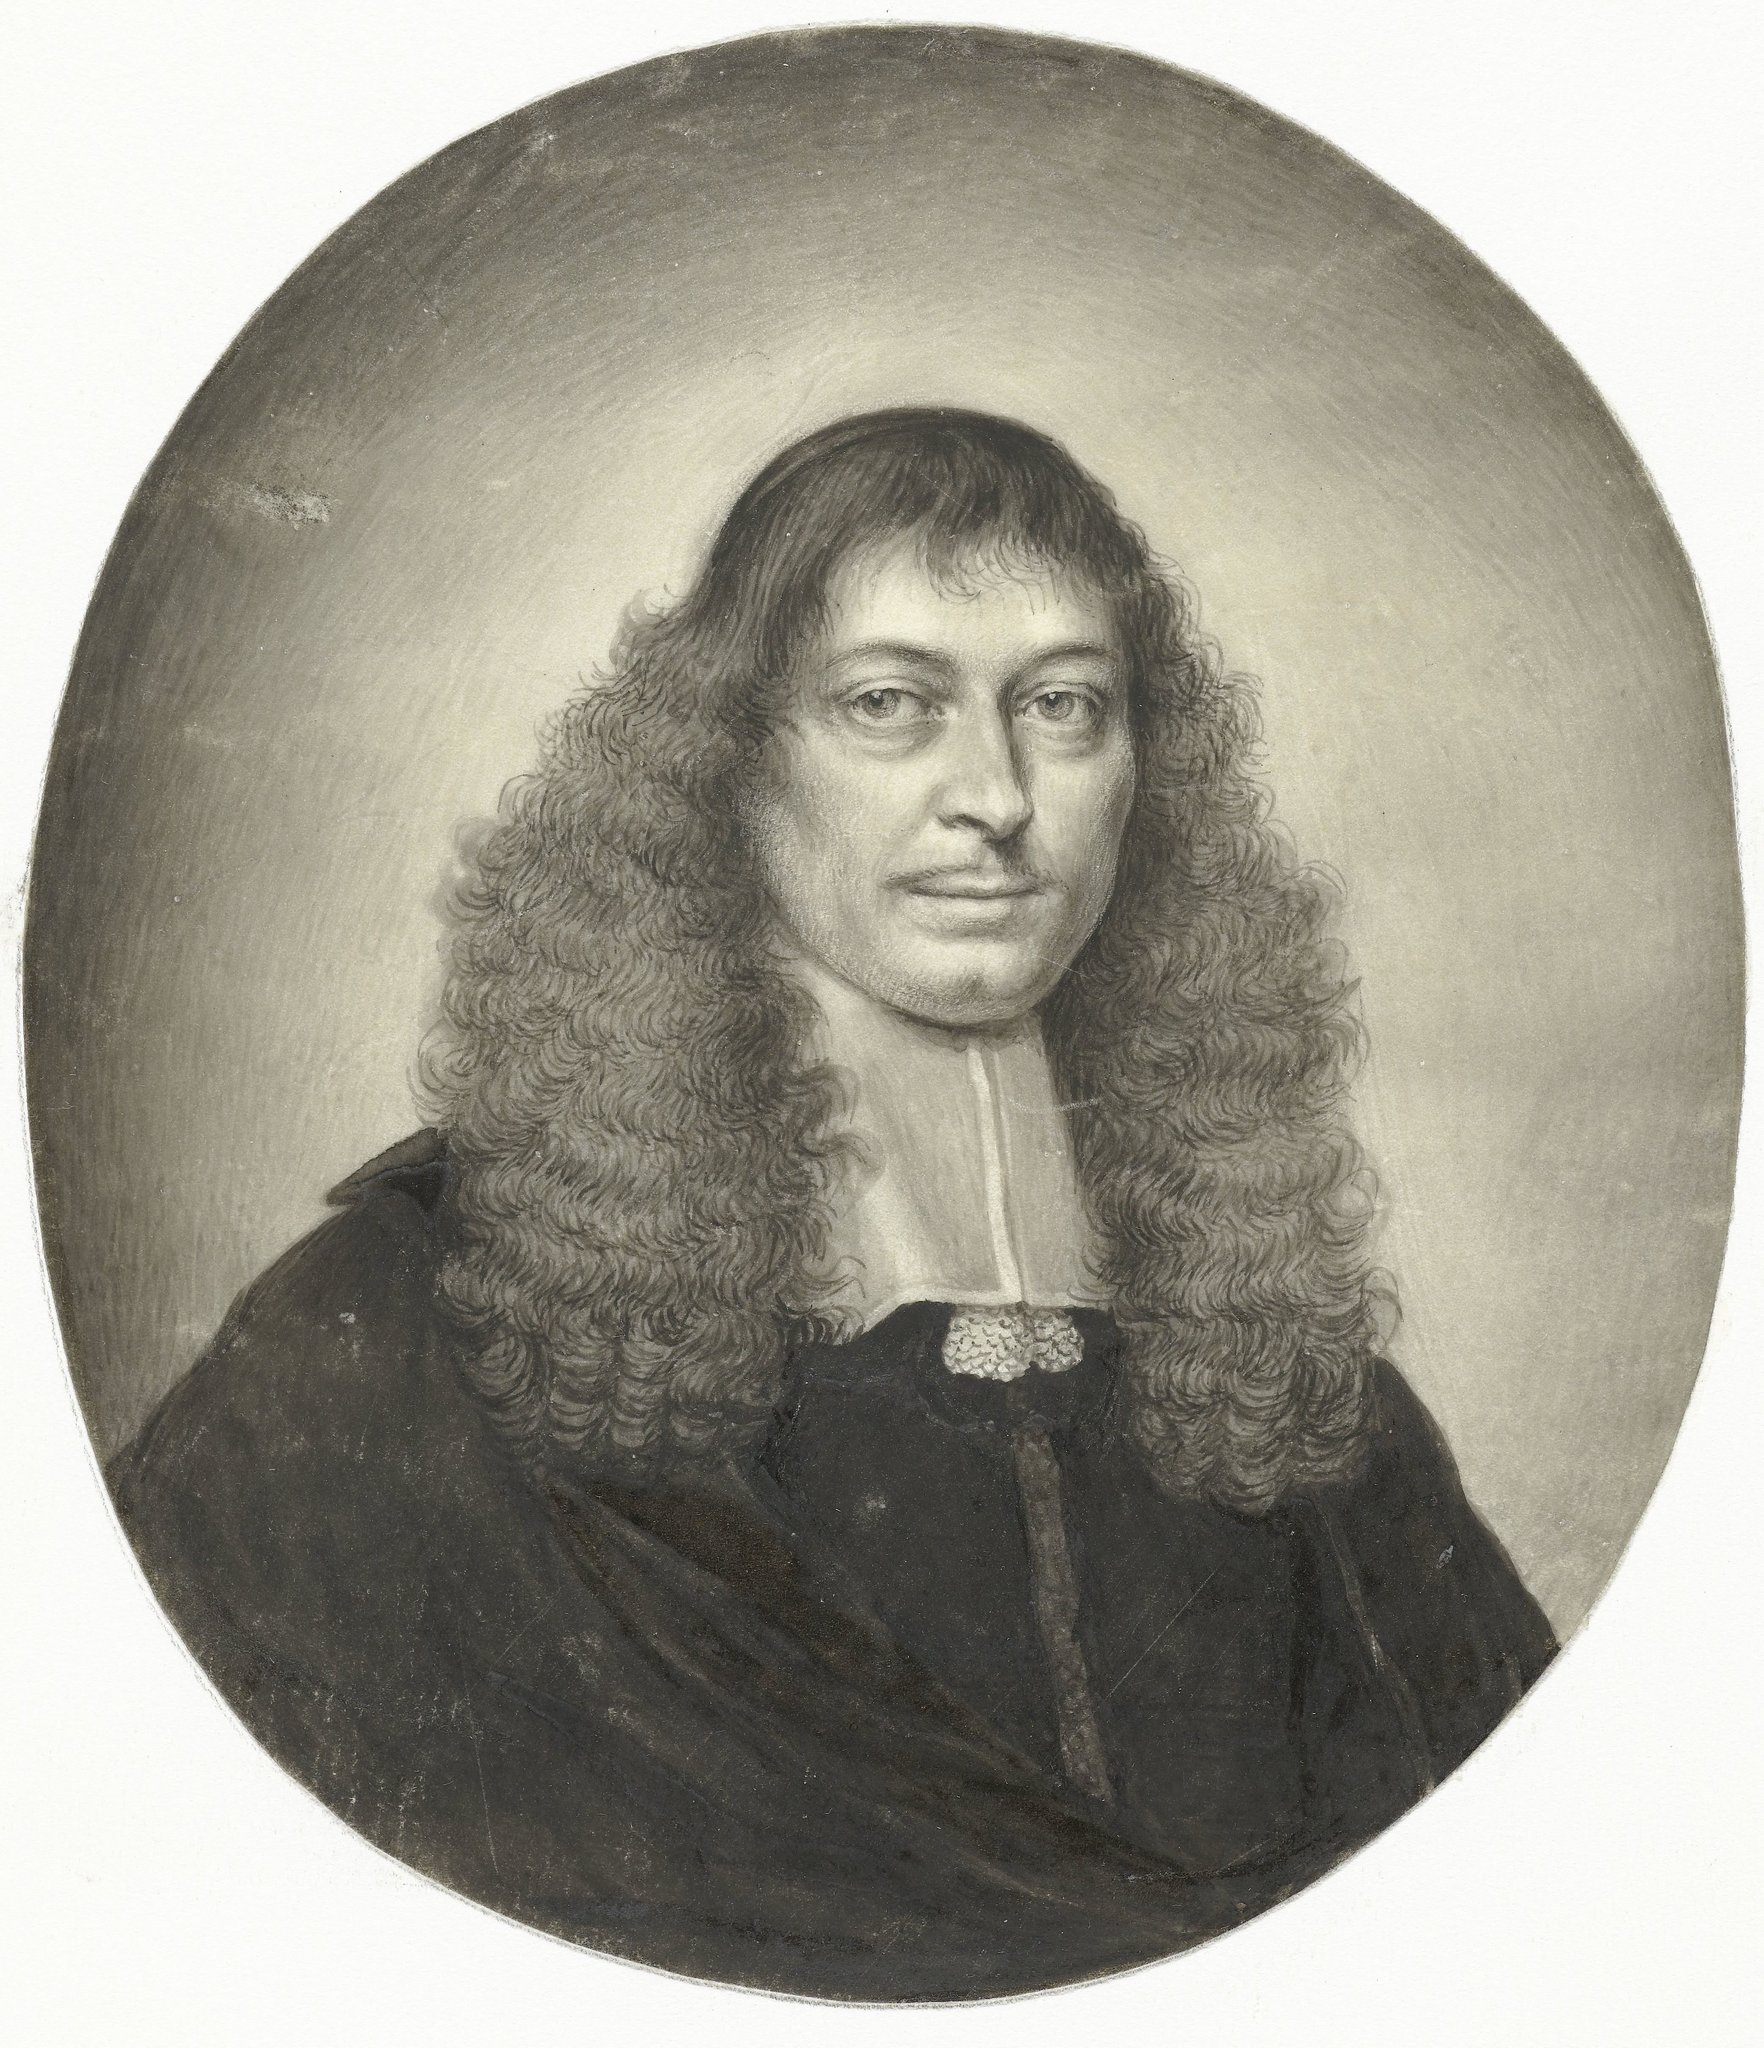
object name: drawing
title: Portret van een onbekende man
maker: pieter cornelisz. van slingelandt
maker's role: draughtsman, painter, print maker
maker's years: 1640-1691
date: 1650-1691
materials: ink, parchment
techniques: brush, pen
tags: anonymous historical person portrayed alone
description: Pendant van "Portret van een onbekende vrouw", inventarisnummer RP-T-1903-A-4764.